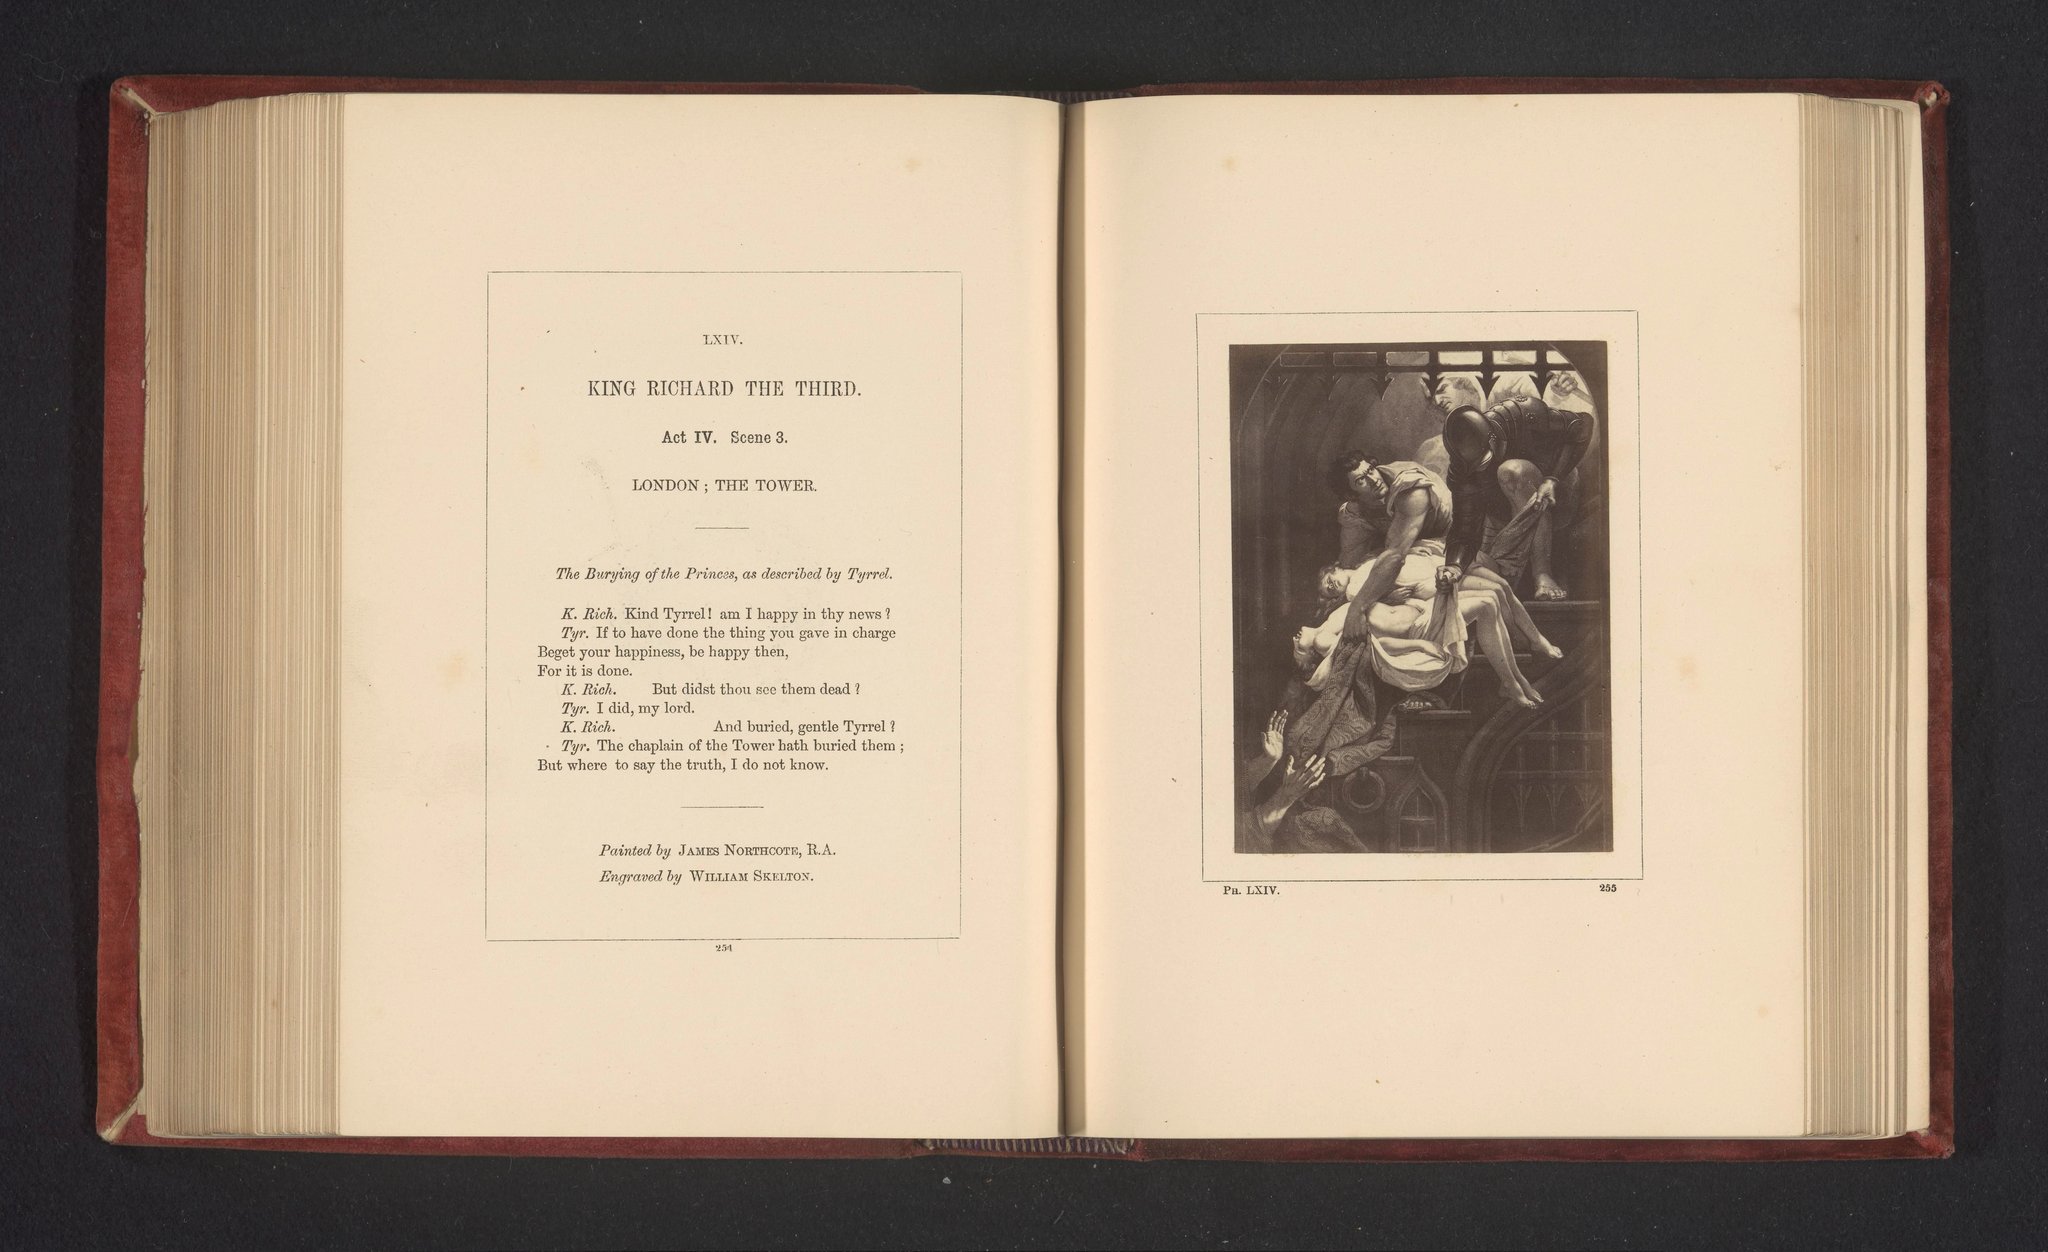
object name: photograph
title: Fotoreproductie van een prent naar een schilderij door James Northcote, voorstellend een scene uit Richard III door William Shakespeare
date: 1854-1864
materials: photographic support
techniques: albumen print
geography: london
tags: specific works of literature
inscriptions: number: ‘Ph. LXIV. 255’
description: Te zien is akte IV, scene 3 met de begrafenis van de prinses.